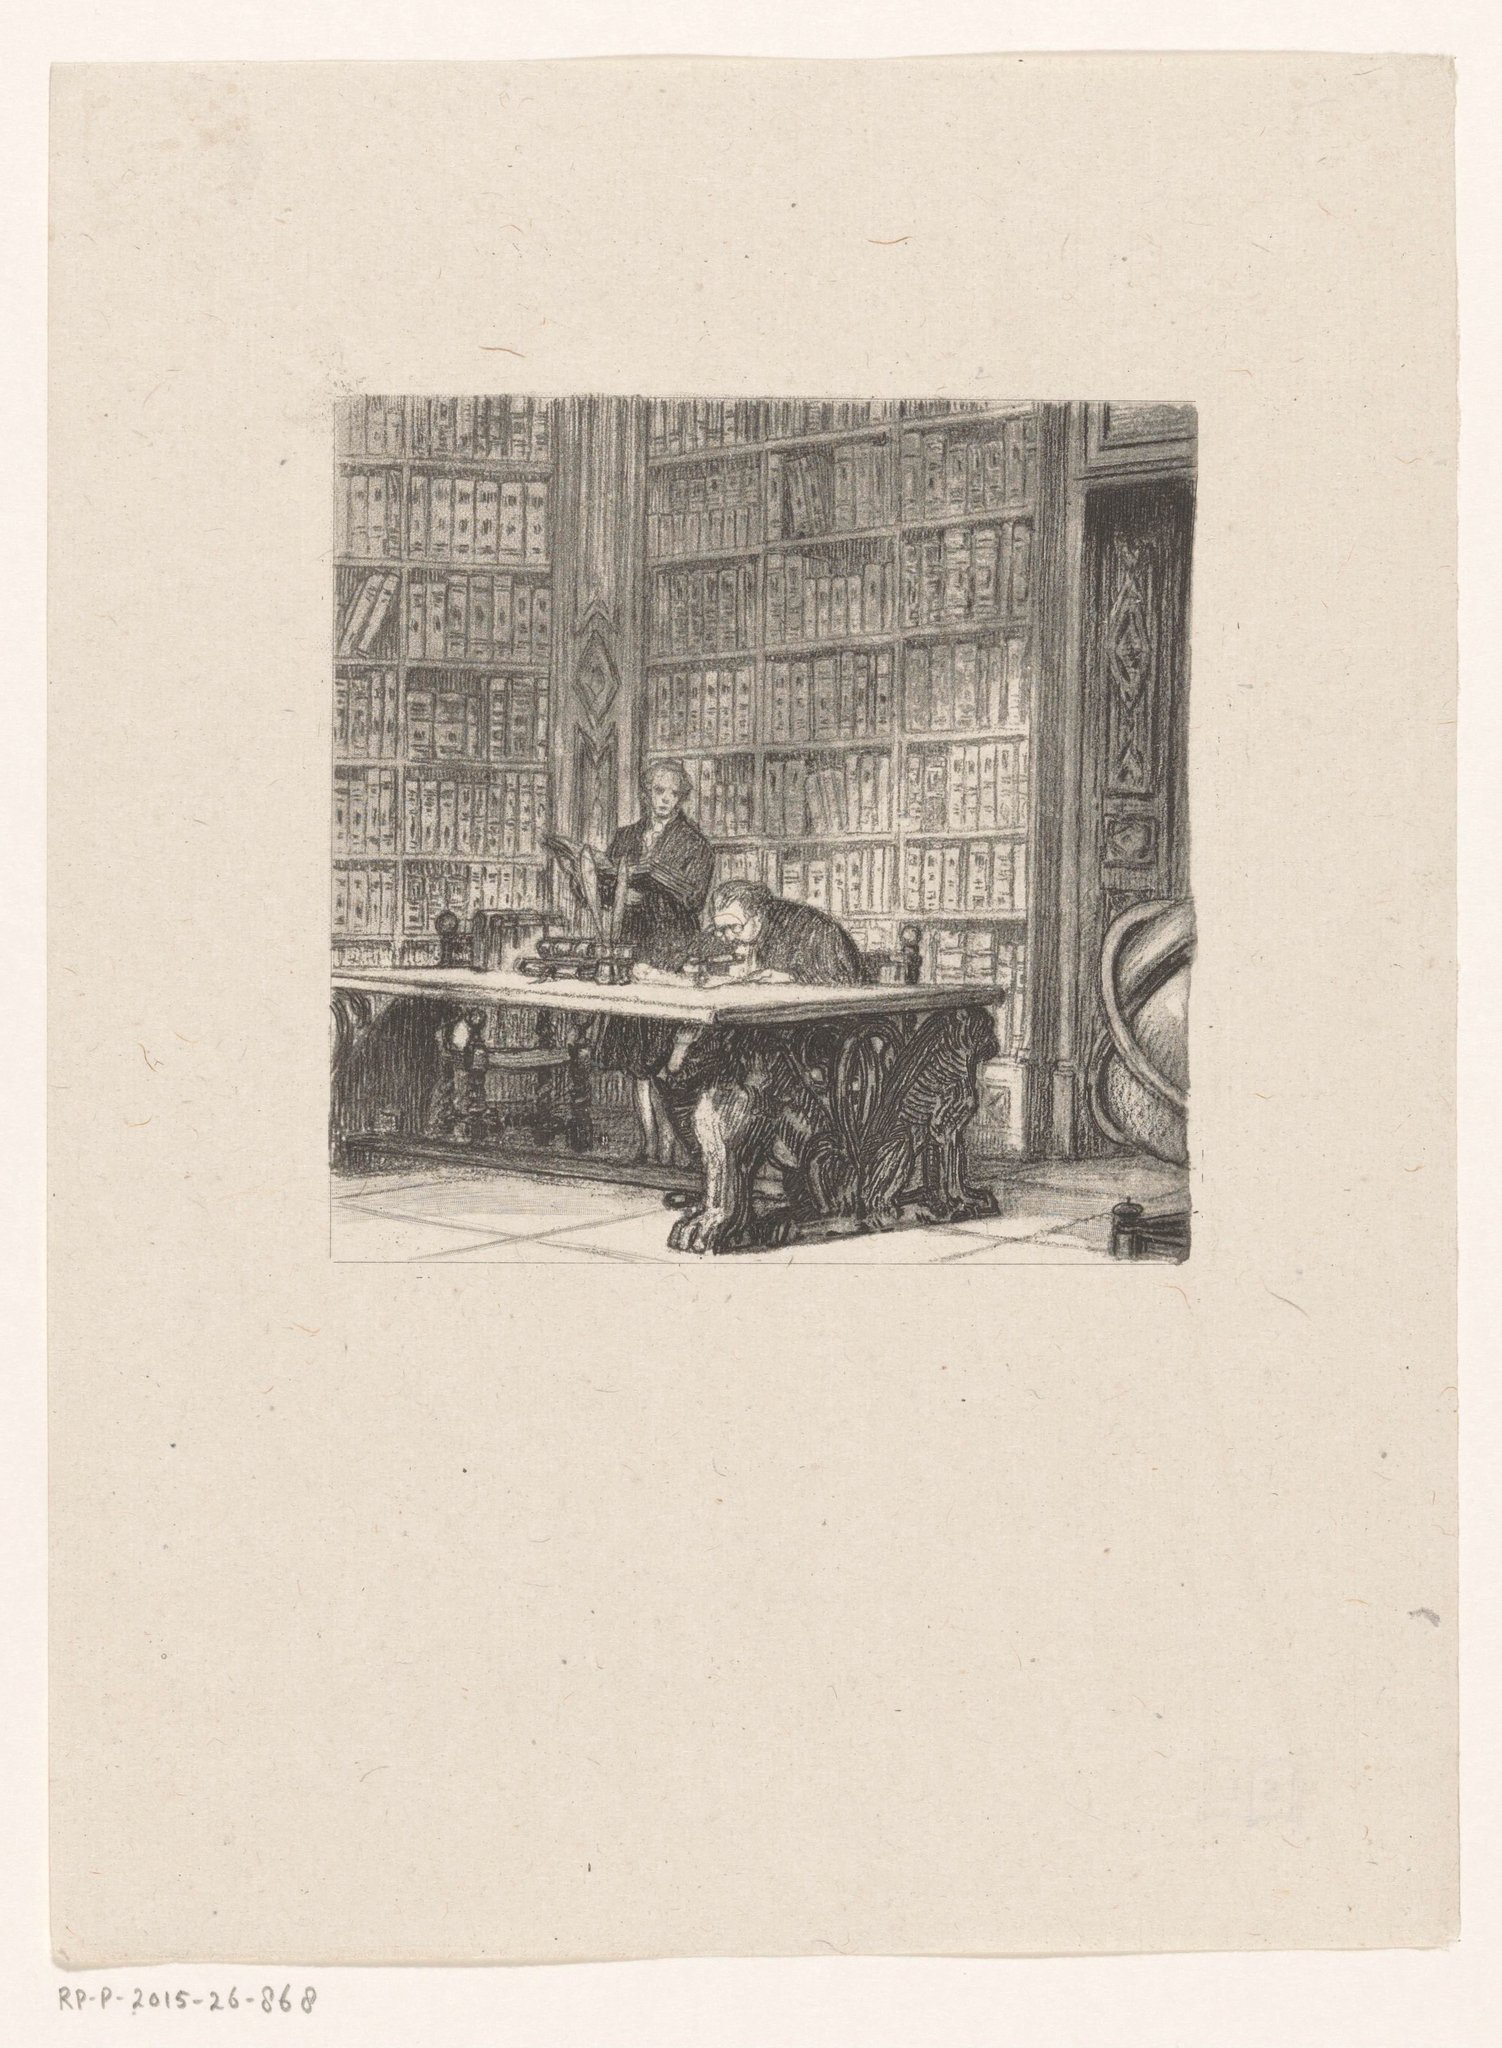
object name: print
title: Twee mannen in een bibliotheek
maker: Anonymous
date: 1850-1925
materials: paper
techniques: lithograph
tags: writing-table, writing-desk, bookshelves, public library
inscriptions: collector's mark: Lugt 4779, collector's mark: Lugt 2228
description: Een van de mannen zit met een vergrootglas achter een schrijftafel waarvan het onderstel bestaat uit leeuwen. Op de voorgrond is een deel van een globe zichtbaar.